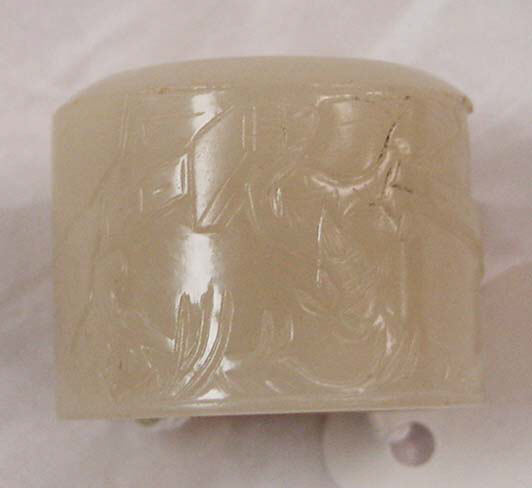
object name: ring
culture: chinese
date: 1801-1900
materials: jade